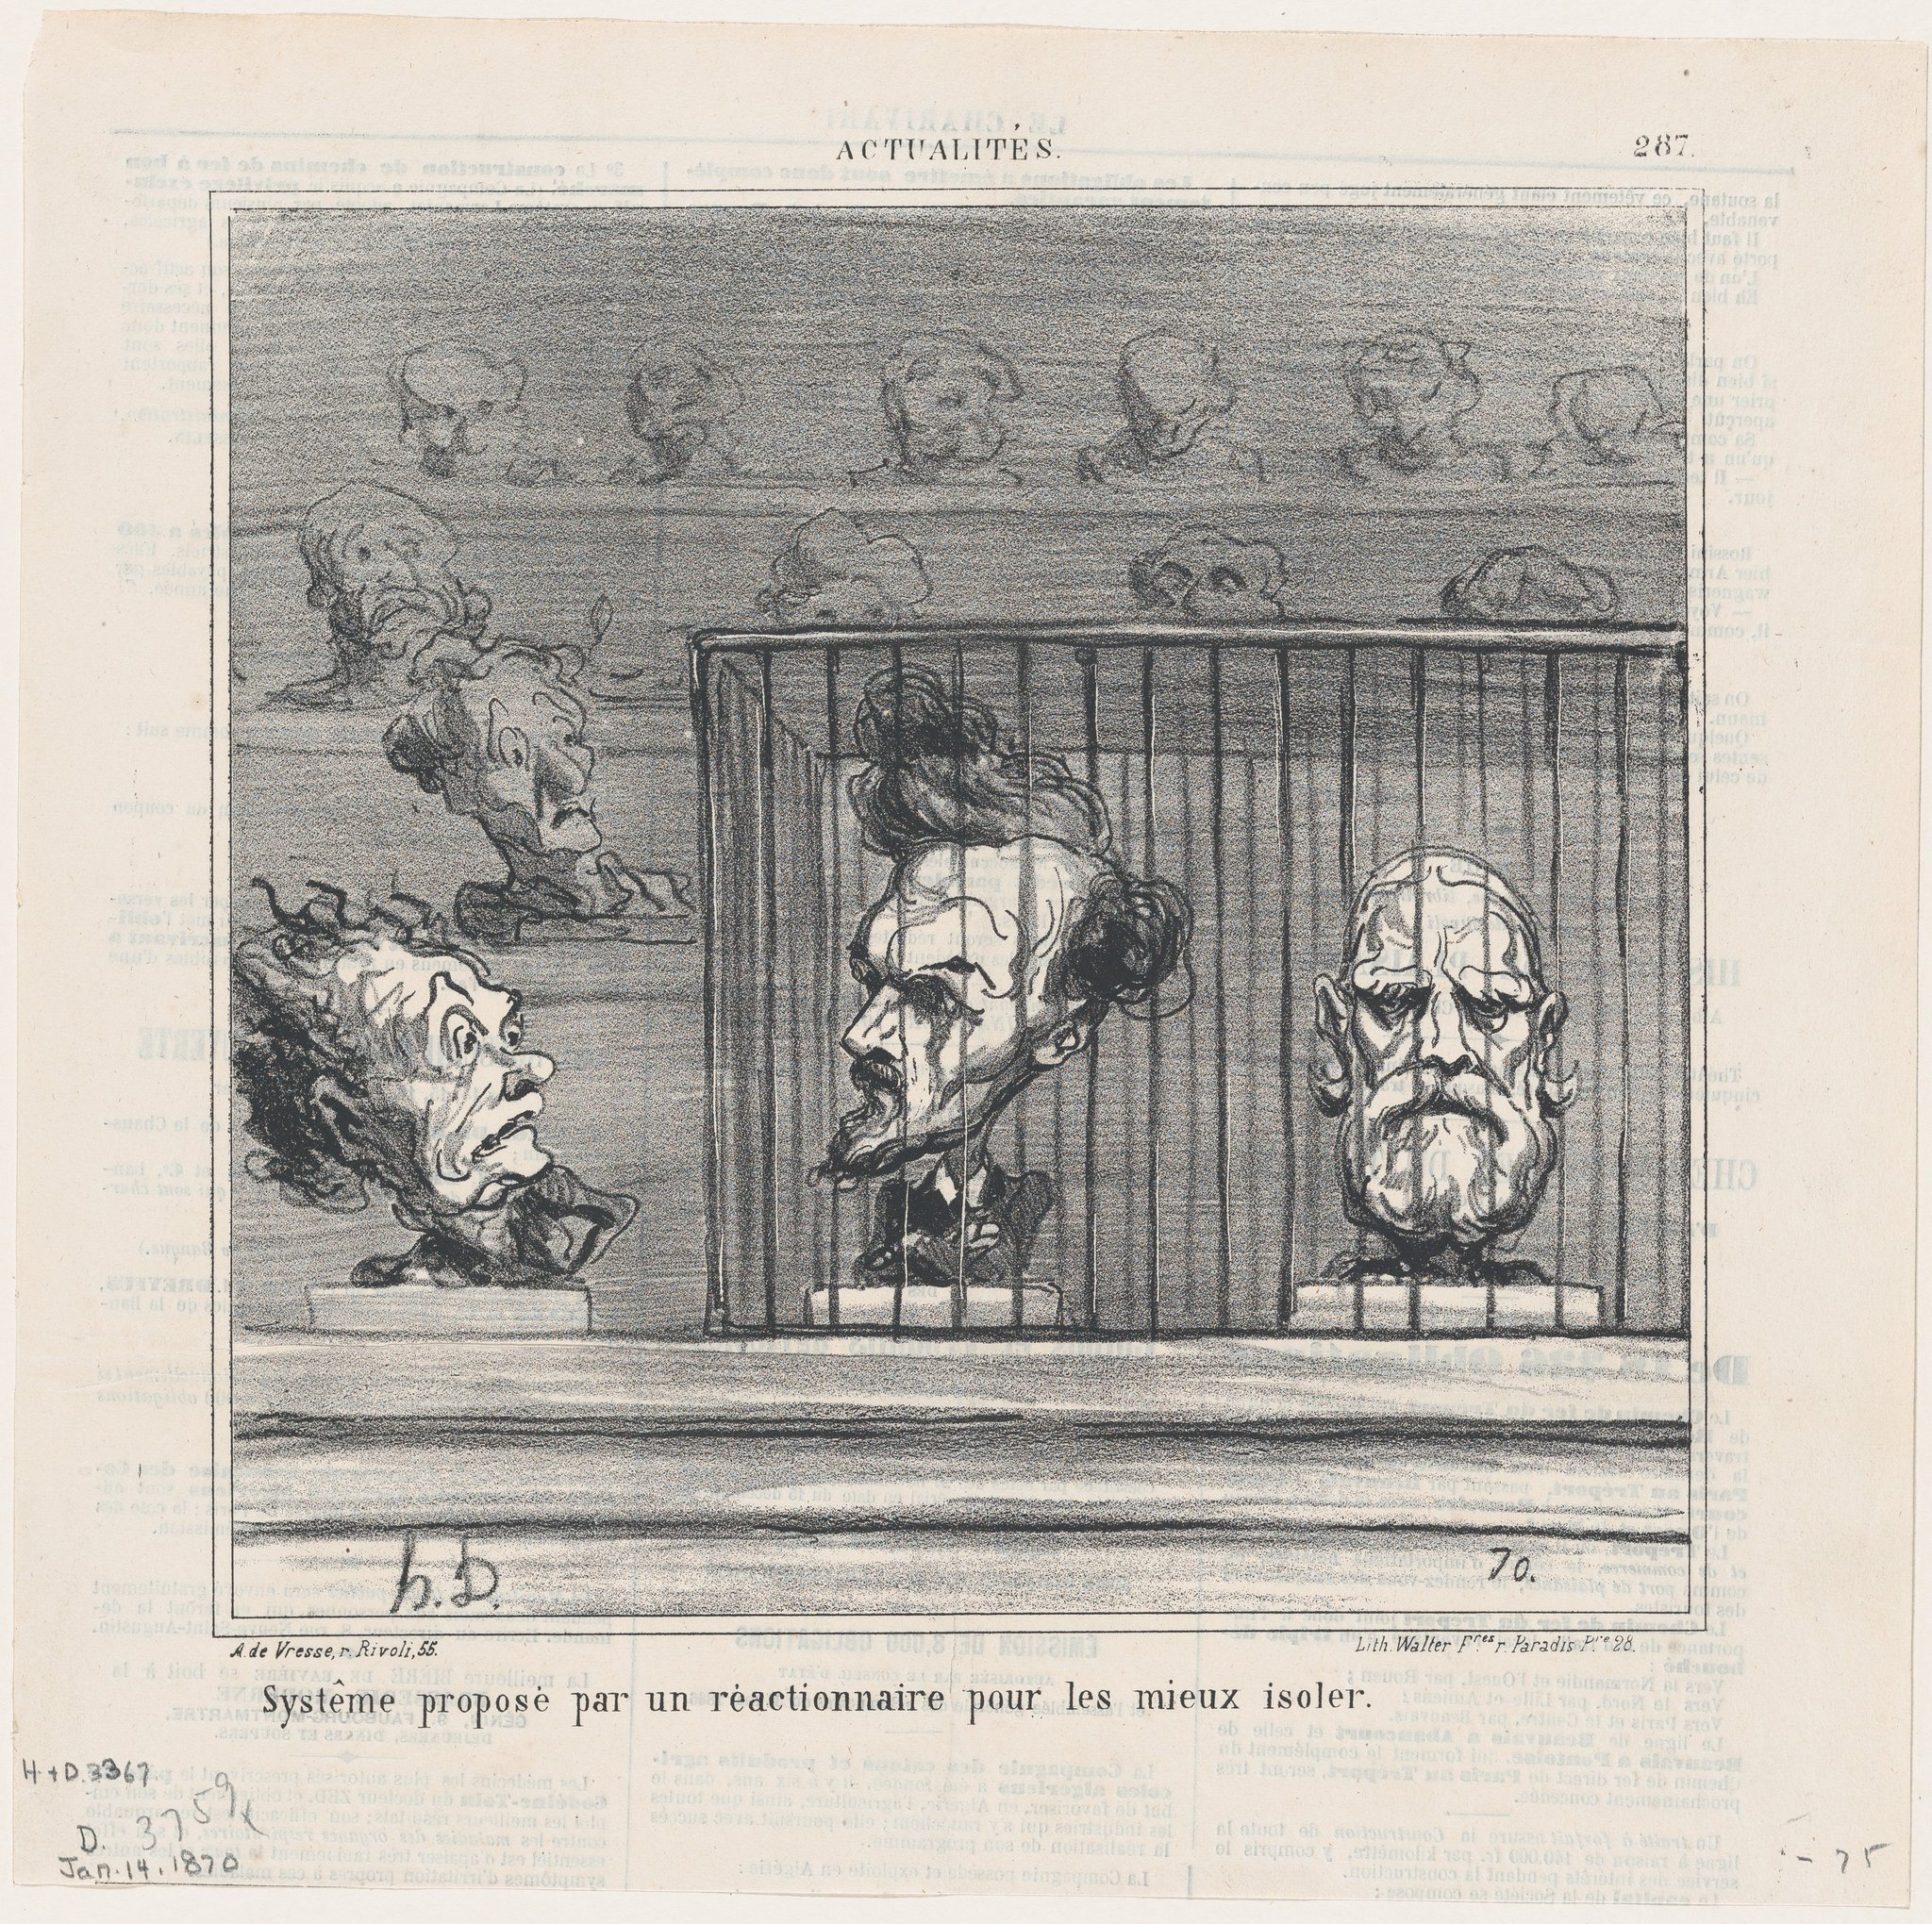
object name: print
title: Proposal for a new system to better isolate reactionnaries, from 'News of the day,' published in Le Charivari, January 14, 1870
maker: honoré daumier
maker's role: artist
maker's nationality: french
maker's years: 1808-1879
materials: paper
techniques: lithograph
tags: satire,heads,fear